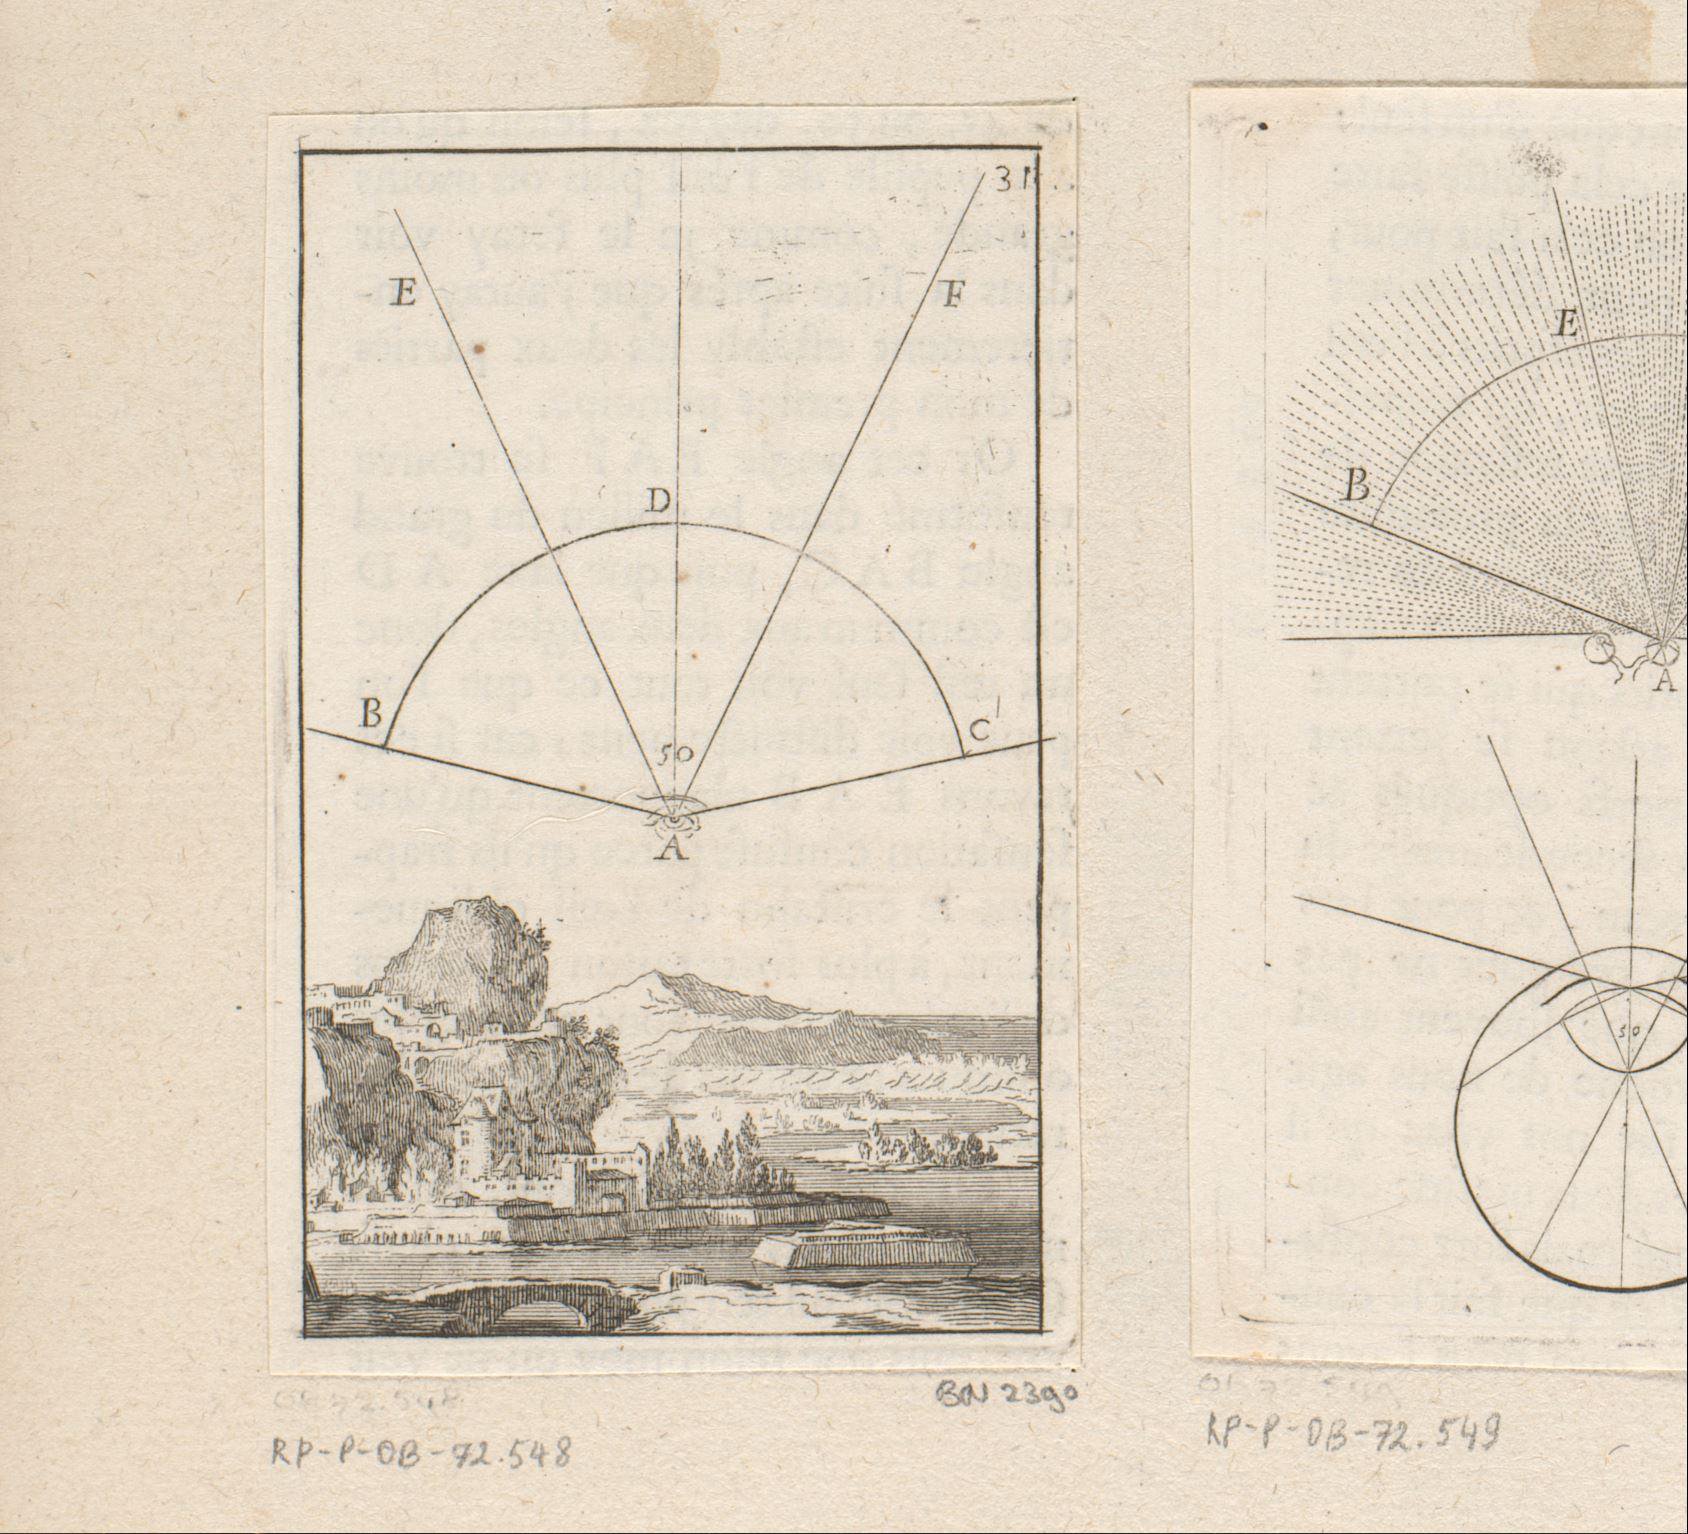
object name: print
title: Geometrische figuur die toont dat de reikwijdte van een blik vijftig graden is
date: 1679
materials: paper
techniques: etching, letterpress printing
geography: france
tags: landscapes, optics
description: Prent uit: Leclerc, Sébastien. Discours touchant le point de veue, dans lequel il est prouvé que les choses qu'on voit (...). Parijs: Thomas Jolly, 1679.